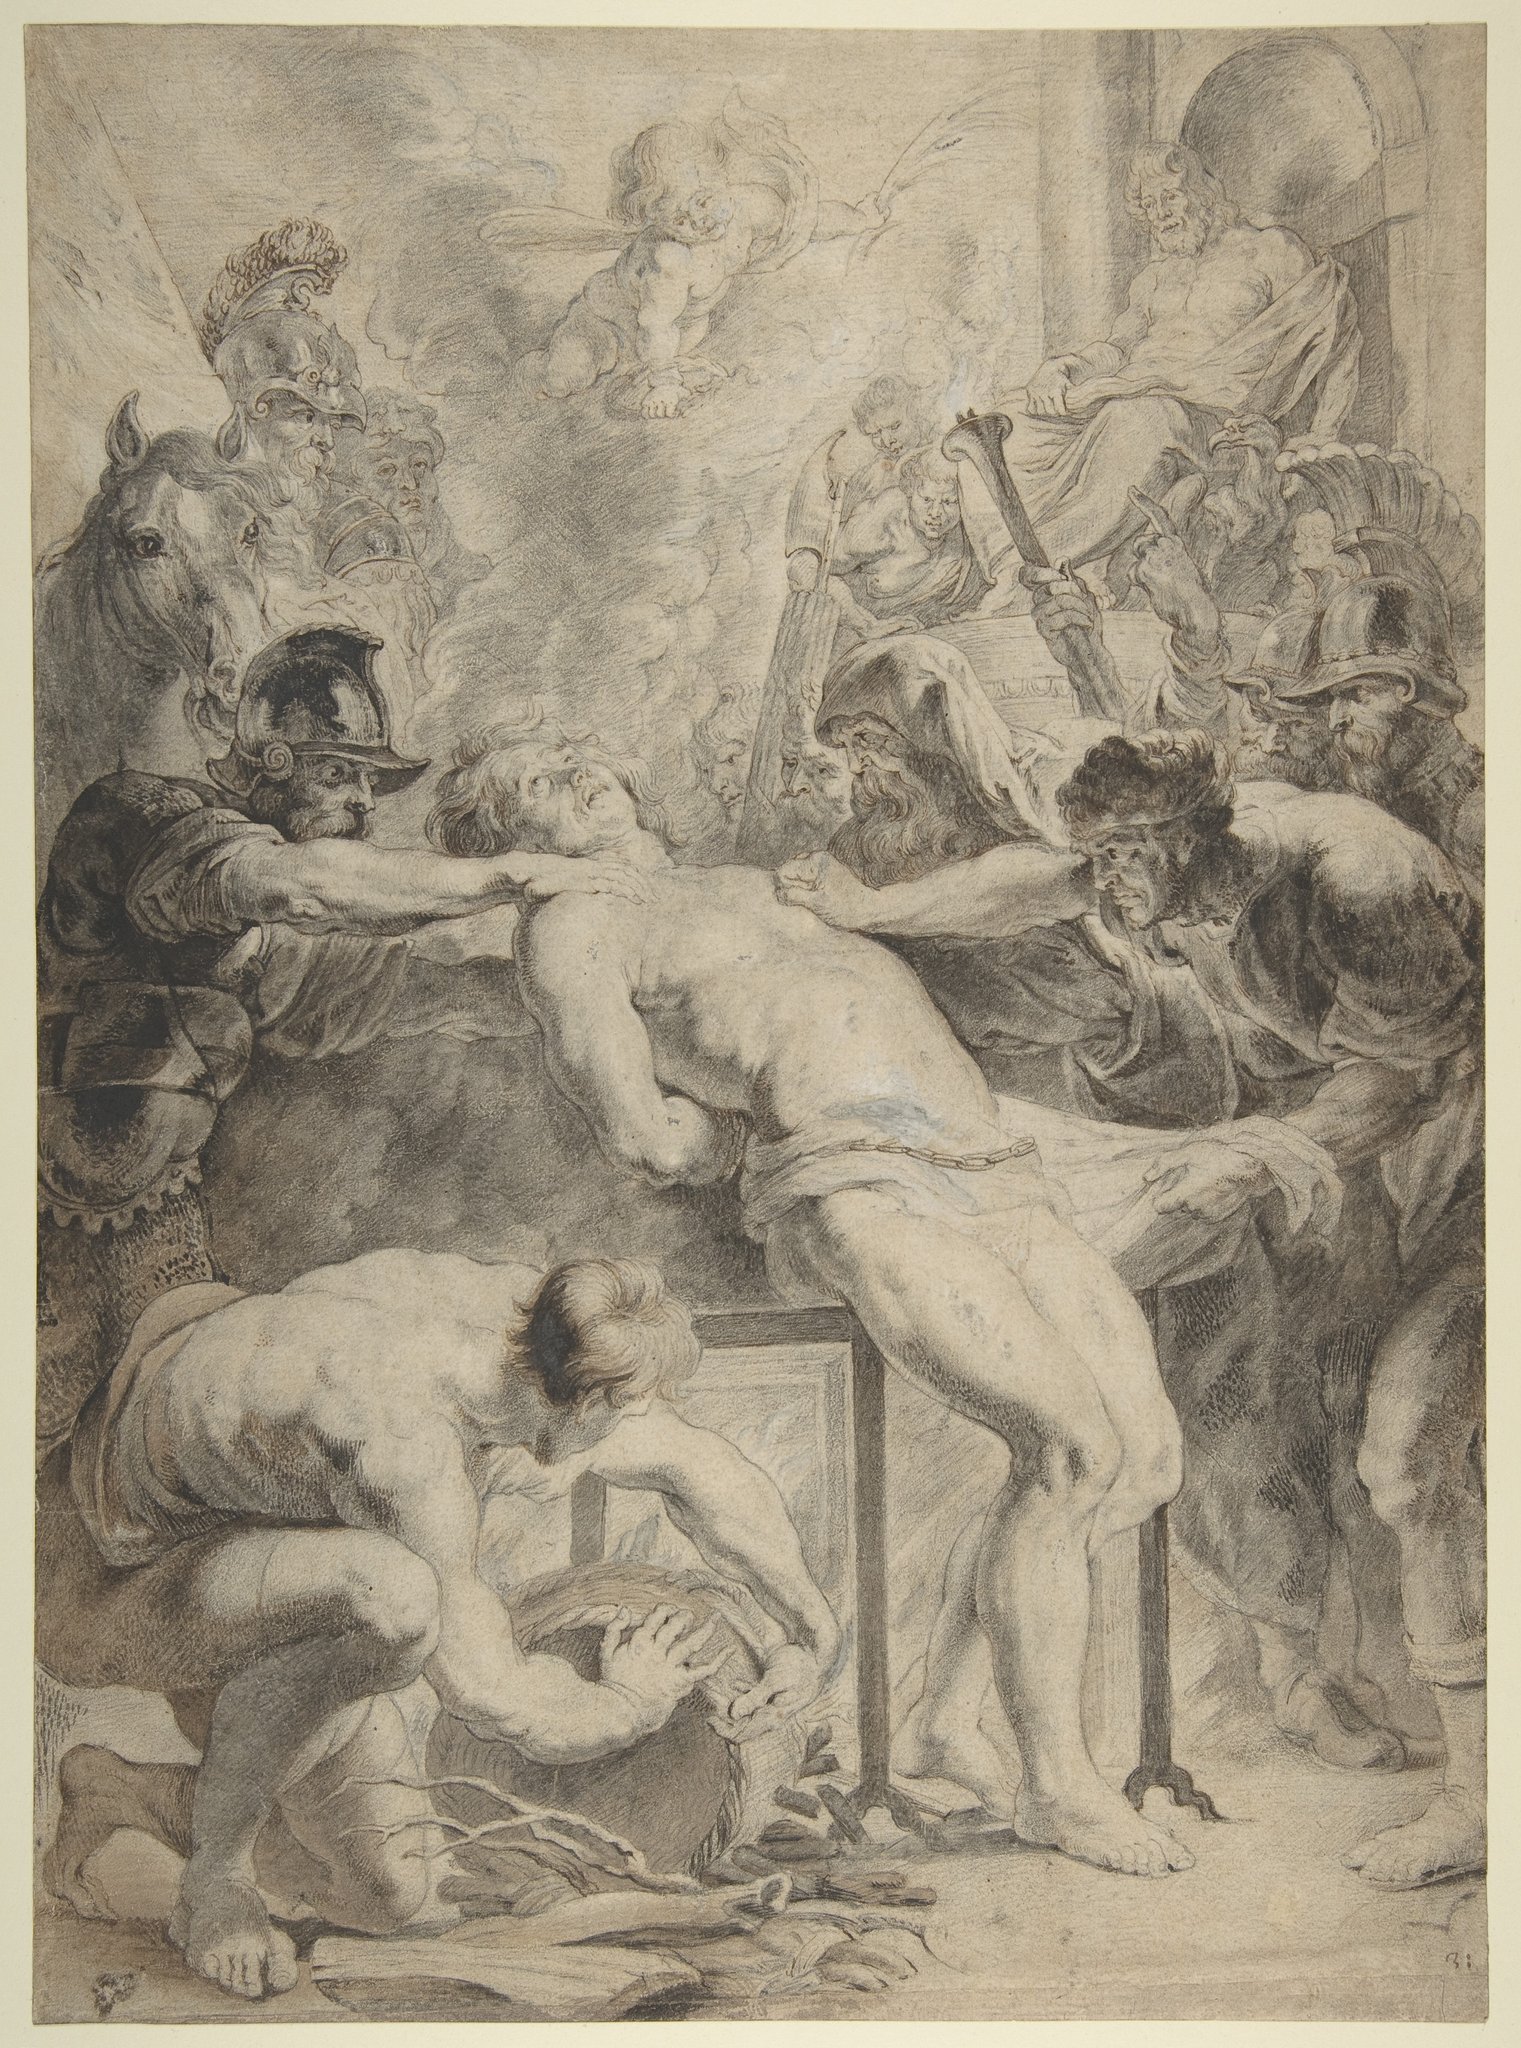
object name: drawing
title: Martyrdom of Saint Lawrence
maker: peter paul rubens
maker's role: artist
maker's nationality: flemish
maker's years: 1577-1640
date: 1601-1633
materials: chalk, ink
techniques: brush, heightening, pen, transfer, wash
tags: suffering,men,saint lawrence